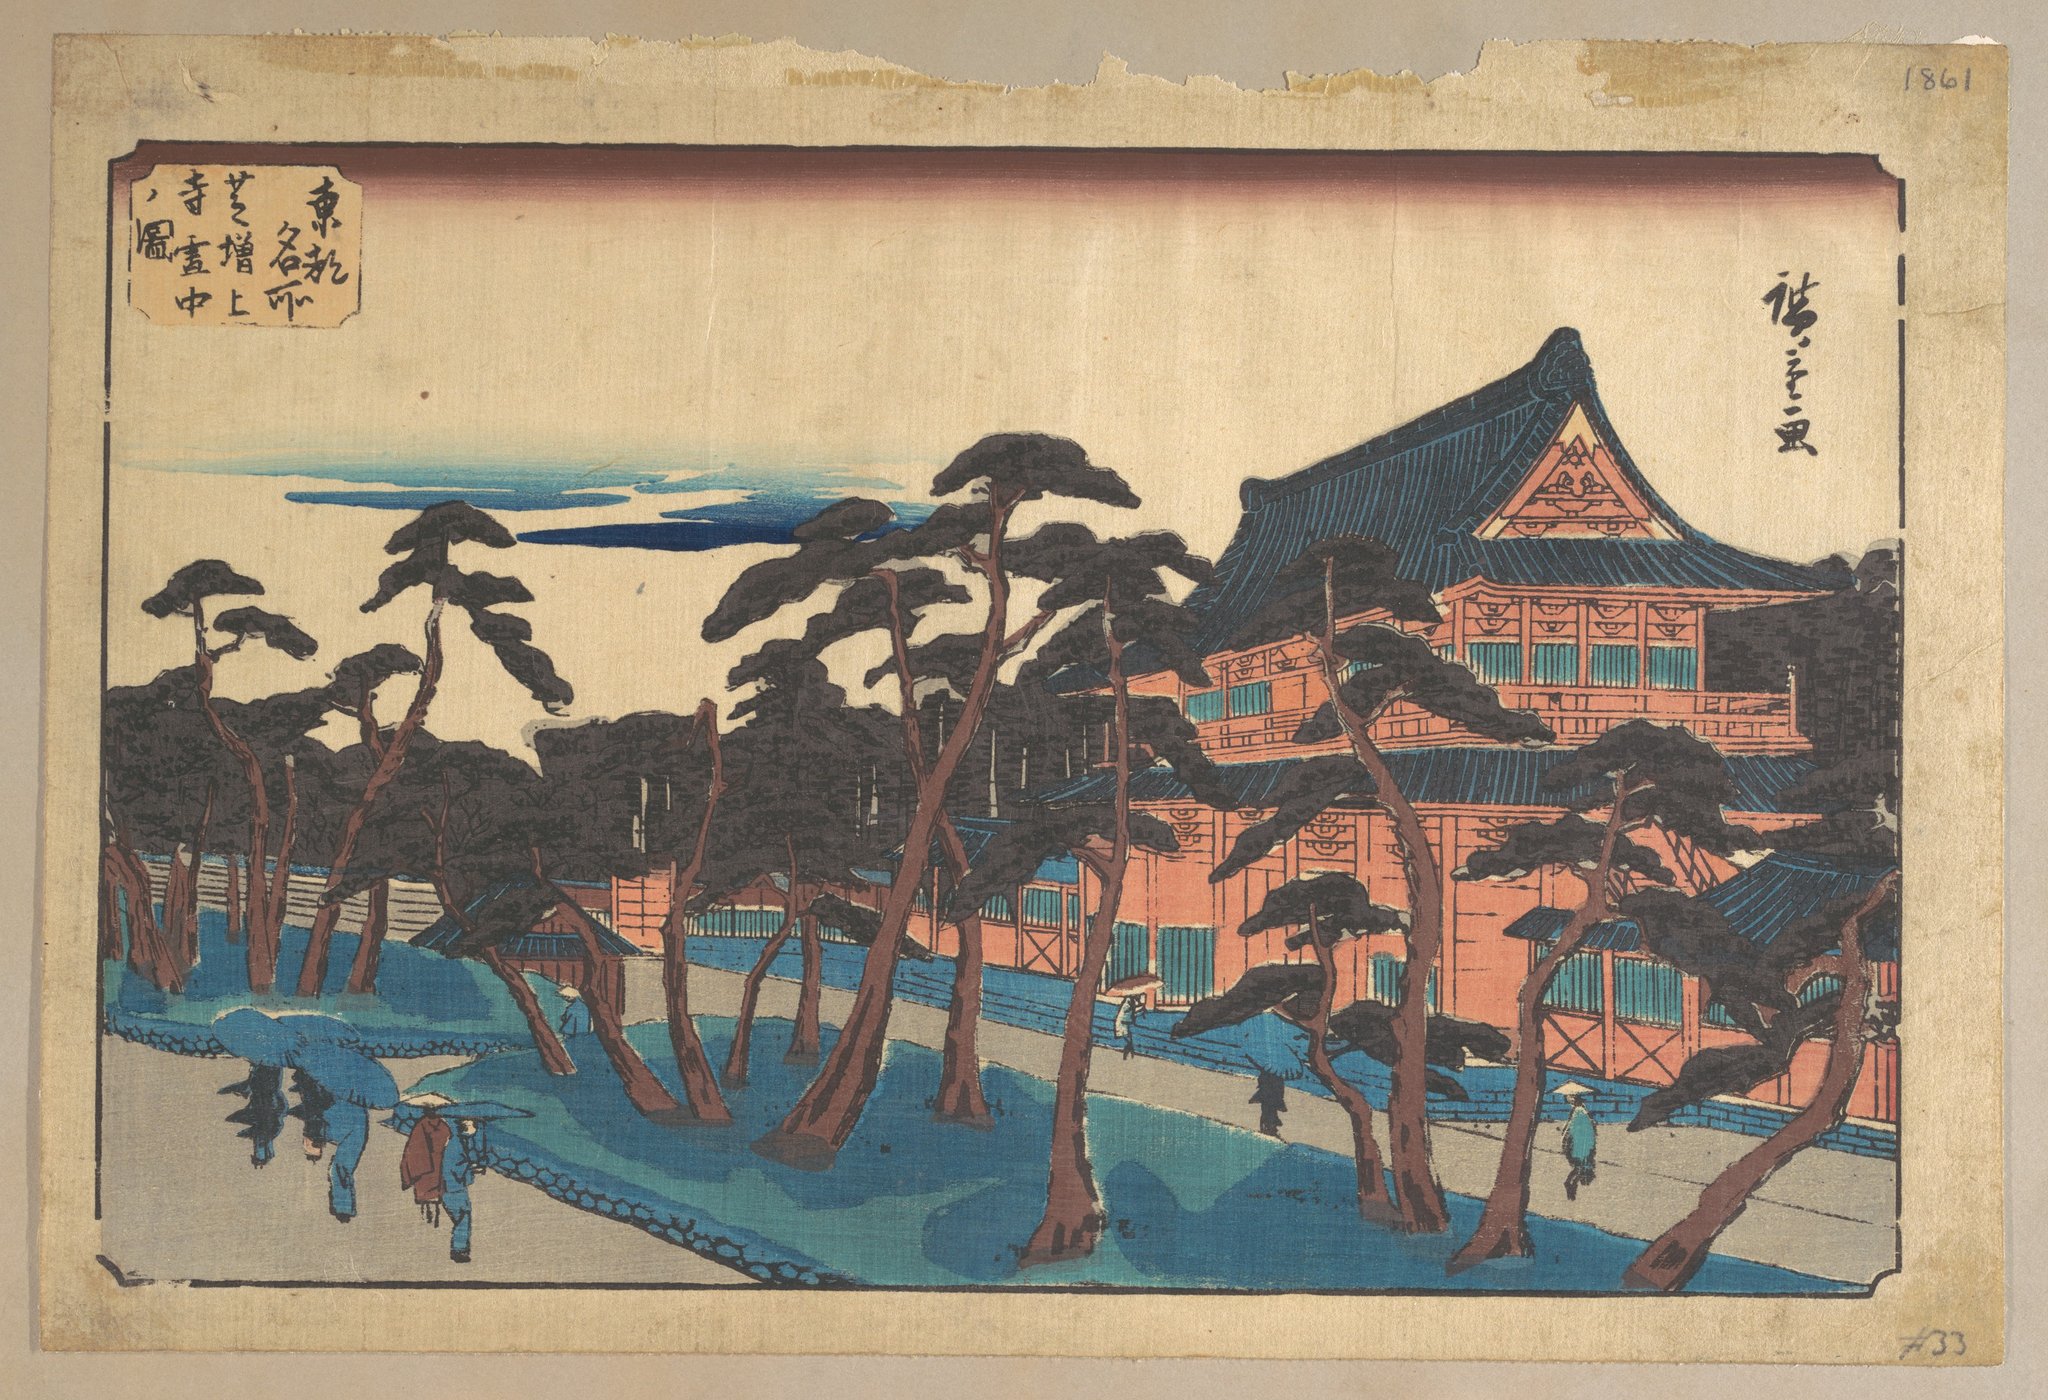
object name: print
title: Zojoji Temple at Shiba in Snow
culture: japanese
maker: utagawa hiroshige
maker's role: artist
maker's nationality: japanese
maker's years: 1797-1858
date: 1797-1858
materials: ink, paper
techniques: woodblock print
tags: human figures,temples,trees